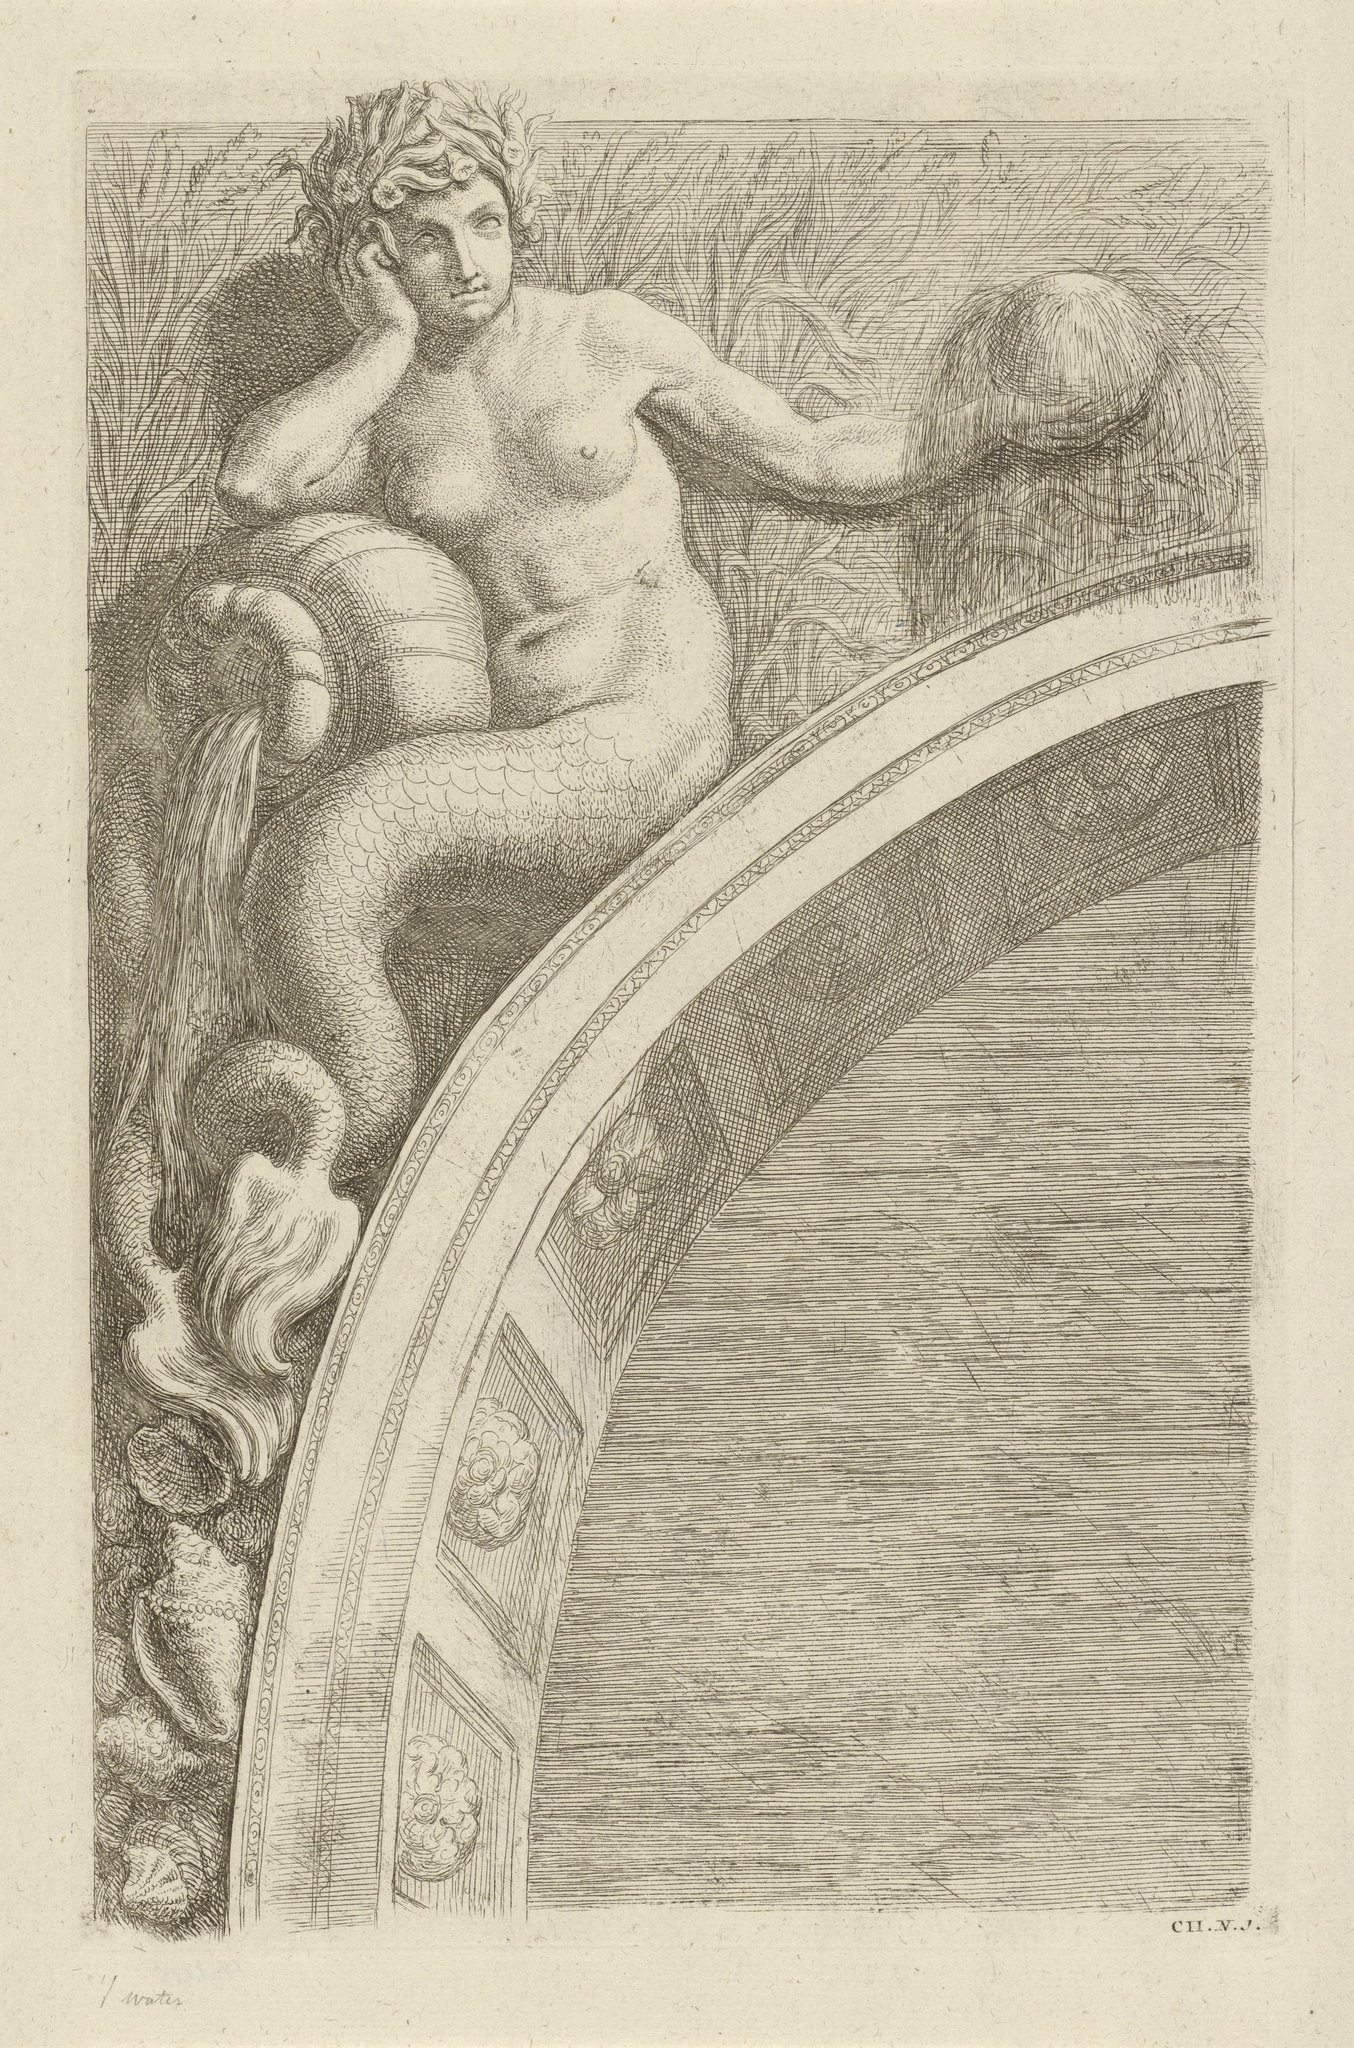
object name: print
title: Reliëf met personificatie van het element Water boven boog aan westzijde van de Burgerzaal in het Stadhuis op de Dam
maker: hubert quellinus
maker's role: print maker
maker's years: 1619-1687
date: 1663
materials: paper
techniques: engraving, etching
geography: amsterdam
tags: merman - aa - mermaid, siren (+ tail), water (one of the four elements), scallop, shell ~ ornament, container of ceramics: jar, jug, pot, vase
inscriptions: collector's mark: Lugt 2228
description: Huidige staat van prent ook gebruikt in: Architecture peinture et sculpture de la Maison de Ville d'Amsterdam, representee en CIX. figures en taille-douce (…). Amsterdam: David Mortier, 1719. En in: Architecture peinture et sculpture de la Maison de Ville d'Amsterdam, representee en CIX. figures en taille-douce (…). Amsterdam: Gerard Valck, 1719. En in: Bouw schilder en beeldhouwkonst, van het Stadhuis te Amsteldam, vertoont in CIX figuuren (…). Amsterdam: Covens & Mortier & Covens Jr., s.a. (1774-1783). Eerdere staat van prent ook gebruikt in: Secunca pars Praecipuarum effigierum ac ornamentorum amplissime Curiae Amstelrodamensis maiori ex parte in cadido marmore effectorum per Artum Quellinium eiusdem Civitatis Statuarium / Het tweede deel Van de voornaemste Statuen ende Cieraten van 't konst-rijcke Stadt-huys van Amstelredam 'tmeeste in Marmer gemaeckt door Artus Quellinus Beelthouwer der voorseyde Stadt. Amsterdam: Artus Quellinus (I), 1663. En in: Secunca pars Praecipuarum effigierum ac ornamentorum amplissime Curiae Amstelrodamensis maiori ex parte in cadido marmore effectorum per Artum Quellinium eiusdem Civitatis Statuarium / Het tweede deel Van de voornaemste Statuen ende Cieraten van 't konst-rijcke Stadt-huys van Amstelredam 'tmeeste in Marmer gemaeckt door Artus Quellinus Beelthouwer der voorseyde Stadt. Amsterdam: Frederik de Wit, 1668.